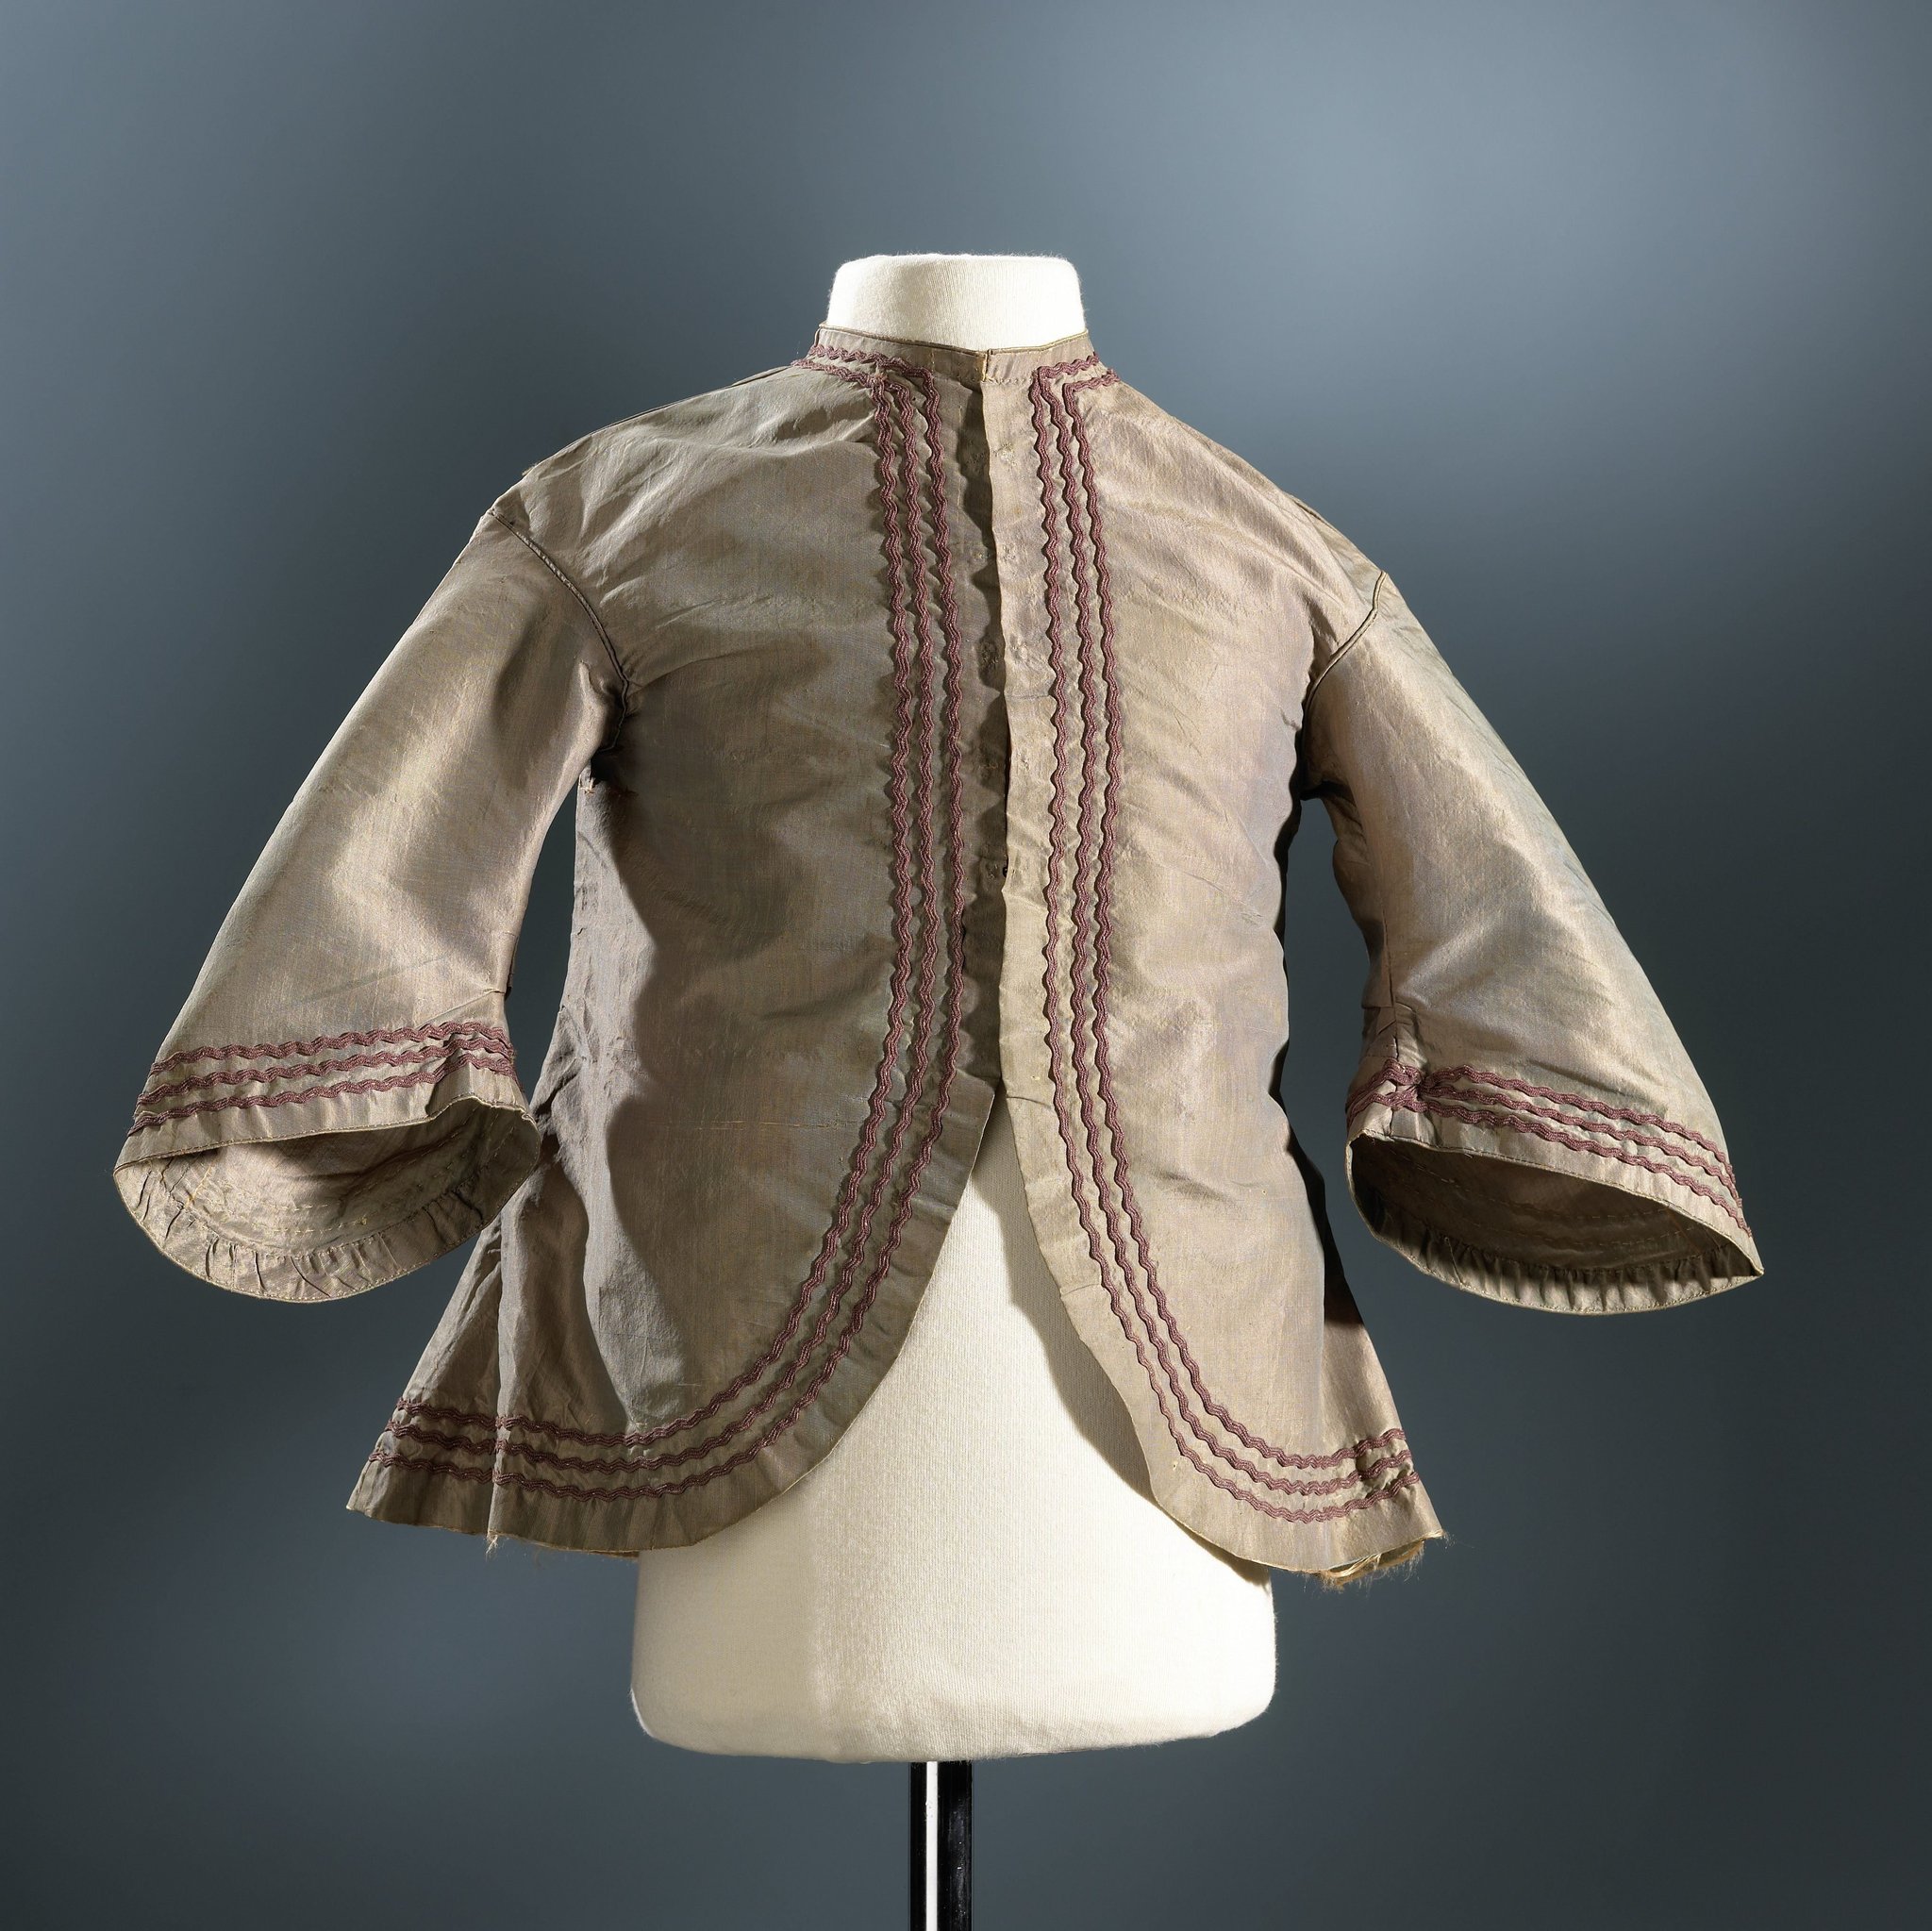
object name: coat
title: Jasje van beigebruine tafzijde, versierd met bruine zigzag band. Rond gesneden voorpanden. Ongevoerd.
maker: Anonymous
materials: cotton, metal, silk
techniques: braiding, casting, weave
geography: netherlands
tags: trijntje van leyden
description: Trijnte van Leyden werd in 1855 geboren en overleed op 10-jarige leeftijd. Haar kleren en enkele persoonlijke bezittingen zijn - ter nagedachtenis aan haar voortijdig overlijden - bewaard gebleven en verefd. Trijntje's oudere zuster Guurtje was de grootmoeder van de schenkster, mevrouw Wilhelmina Buys. Van Leyden komt van haar moeders kant.